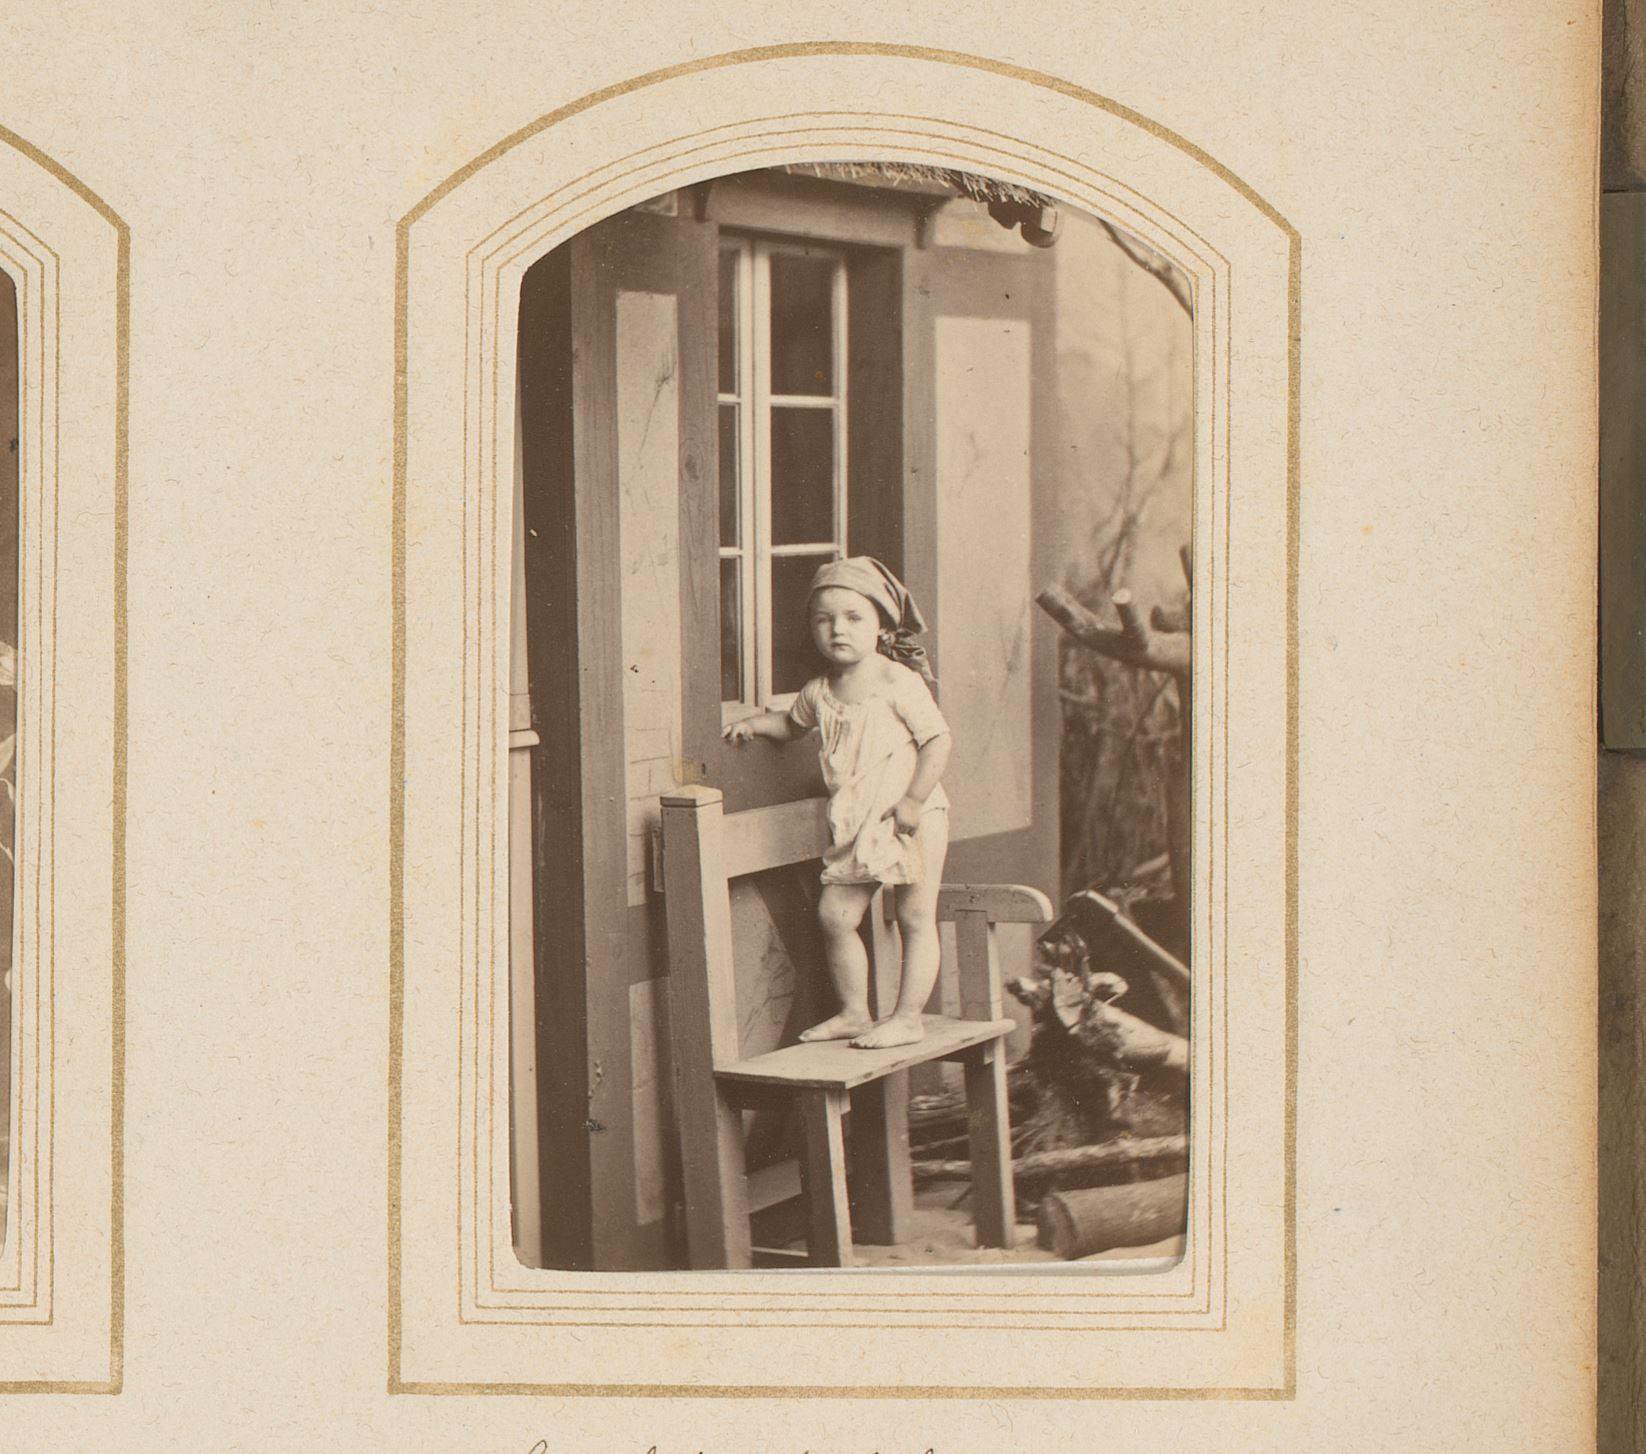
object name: album leaf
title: Kind staande op bank voor huis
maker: Anonymous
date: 1870-1890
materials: cardboard, photographic support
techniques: albumen print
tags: bench, child, façade (of house or building)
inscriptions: annotation: ‘[...]’